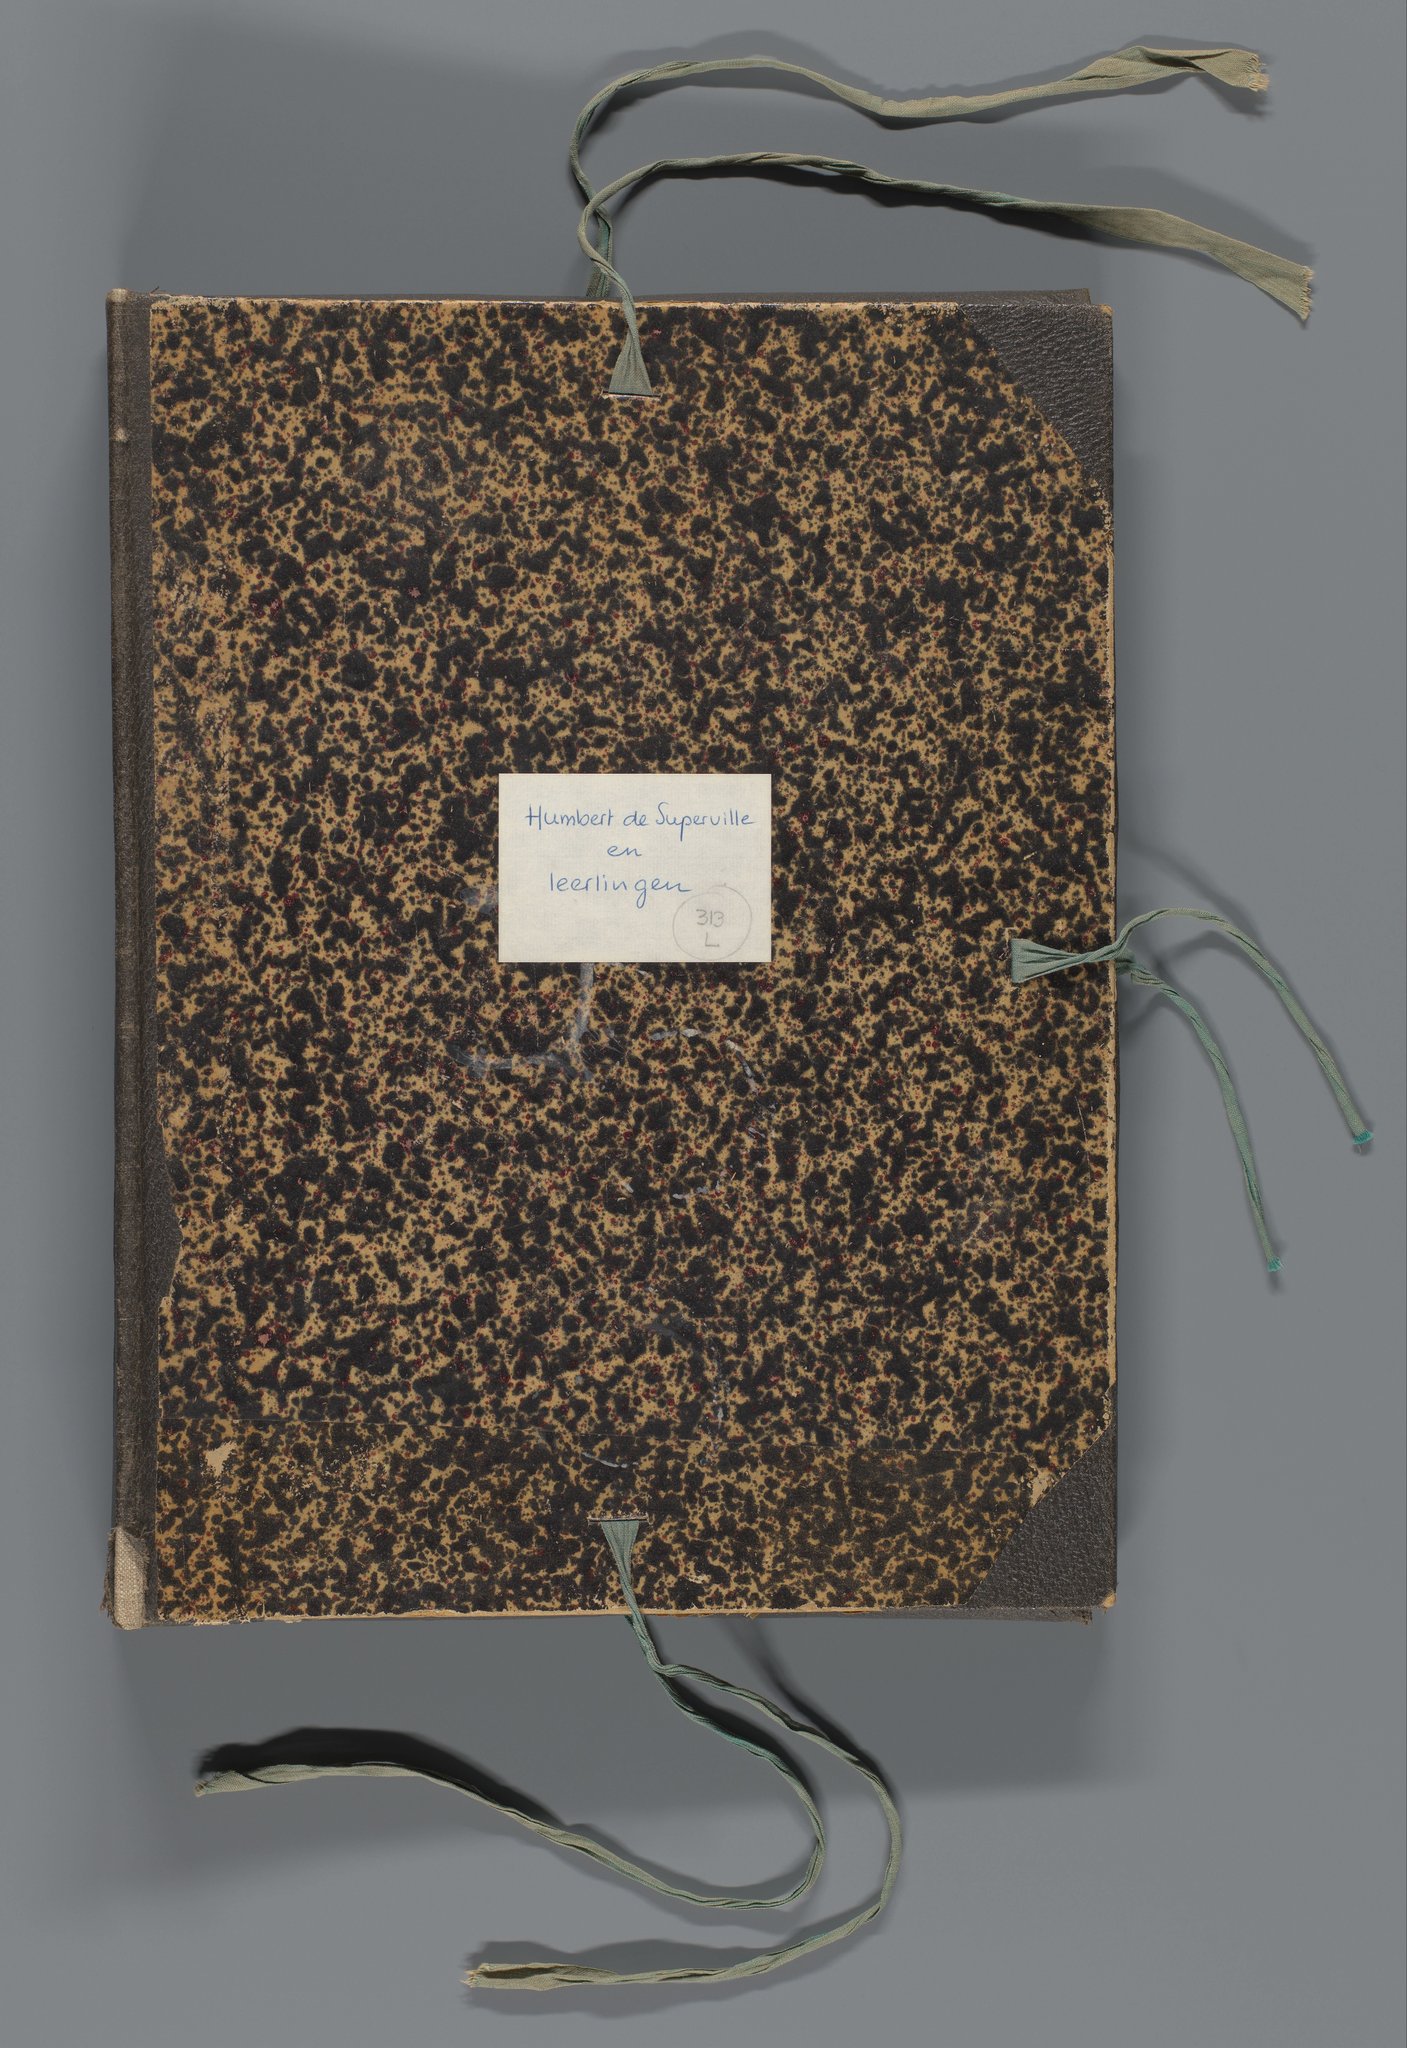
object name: folder container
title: Portefeuille voor 83 tekeningen, 6 prenten en 1 brief van Humbert de Superville en enkele van zijn leerlingen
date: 1814-1817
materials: cardboard, linen, paper, textile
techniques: marbling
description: Aan deze map zijn ook meerdere tekeningen toegevoegd die niet tot de oorspronkelijke verwerving van 1969 behoren. Hiertoe behoort een aantal tekeningen geschonken in 1987 en één tekening verworven in 1881 als onderdeel van de collectie Frederik Muller.